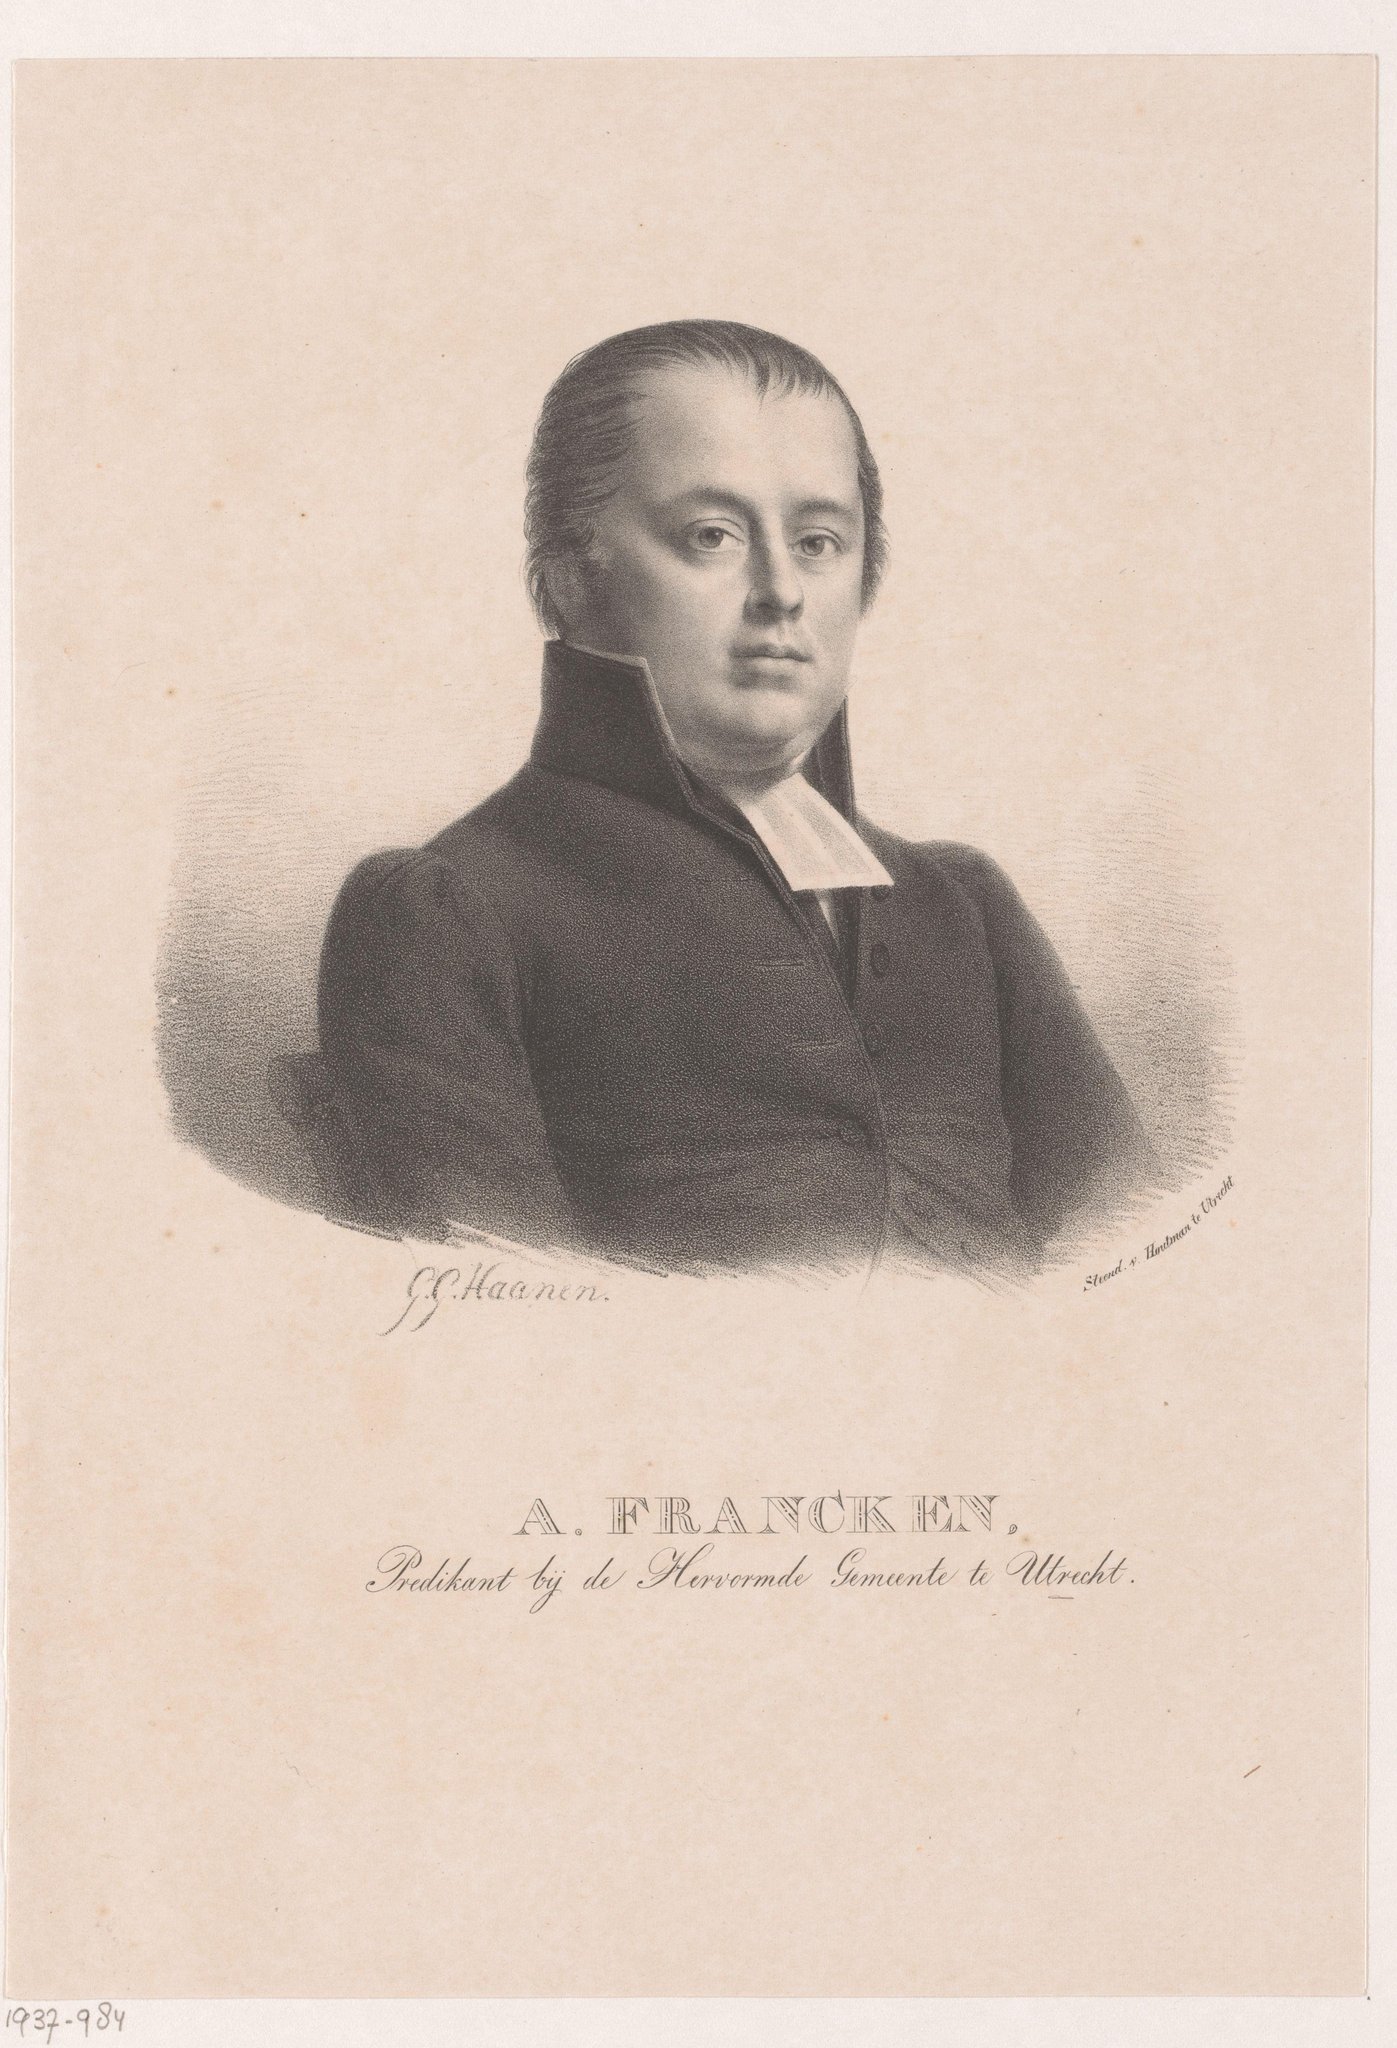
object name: print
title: Portret van Ahasueros Francken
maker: george gillis haanen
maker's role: draughtsman, painter, print maker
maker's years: 1807-1881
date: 1817-1881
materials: paper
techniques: lithograph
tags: nijmegen, historical persons (+ (full) bust portrait)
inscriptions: collector's mark: Lugt 2228, collector's mark: Lugt 2760